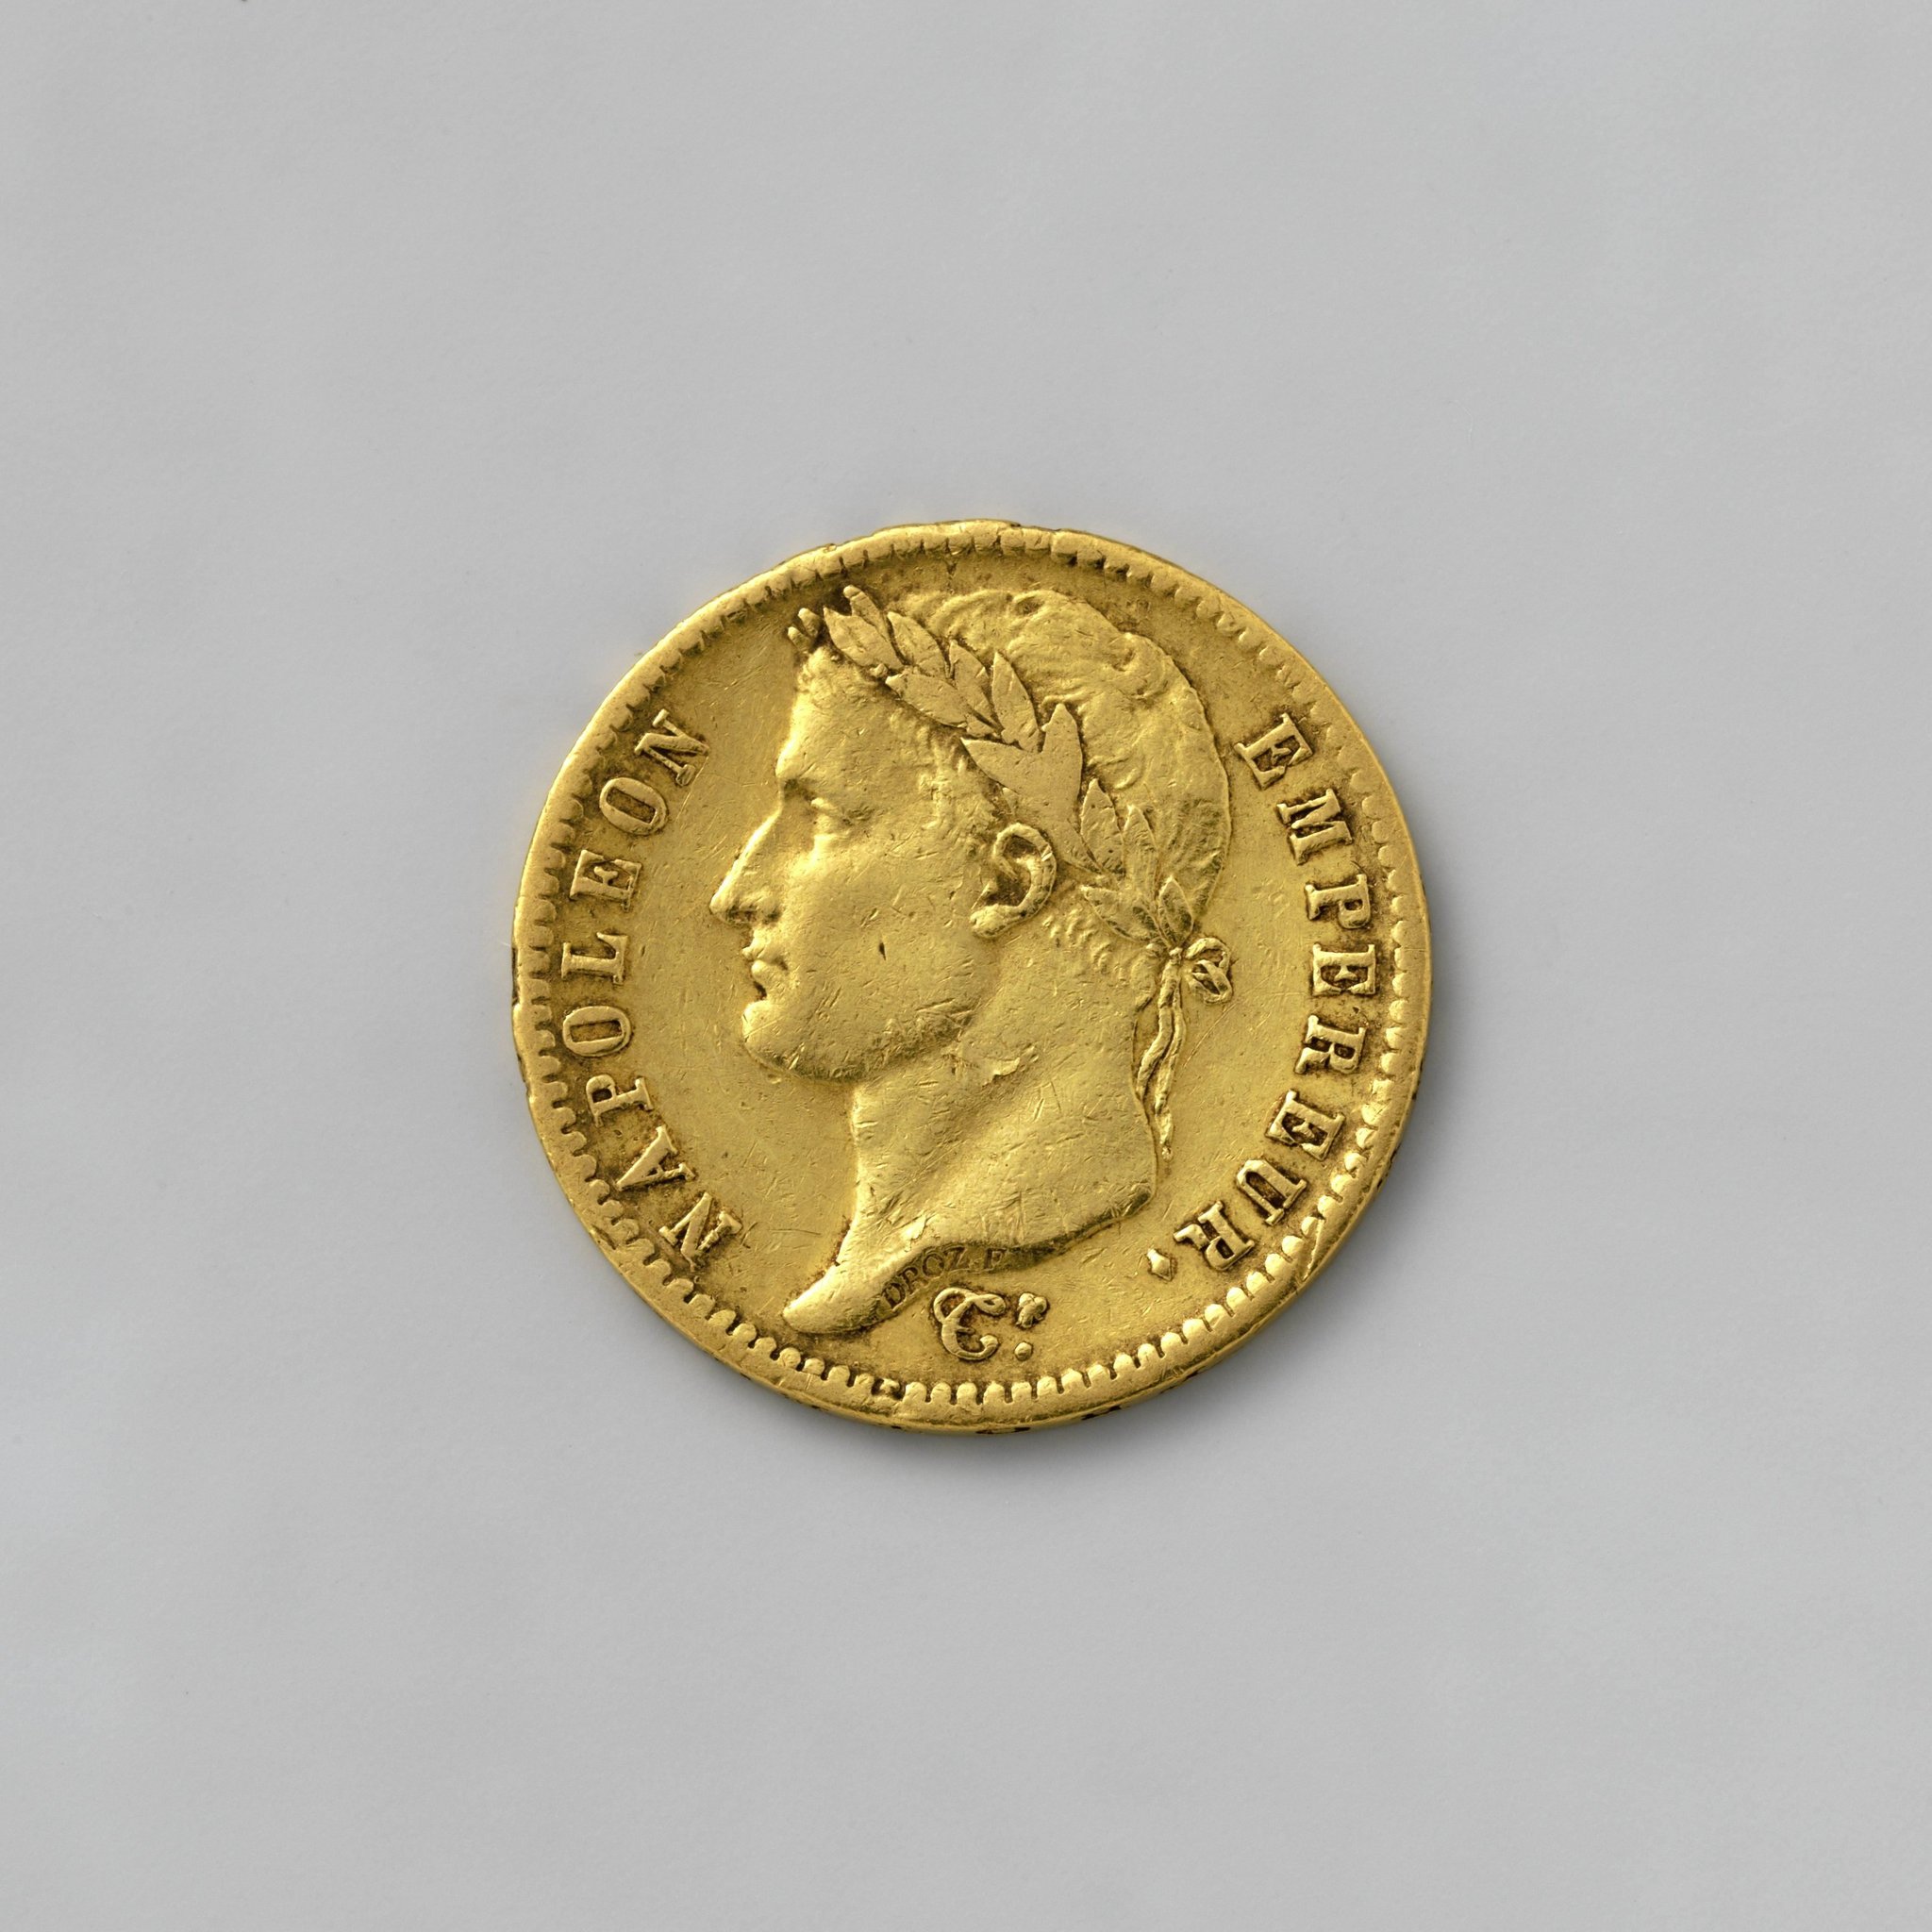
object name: twintig franc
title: Nederland, bij Frankrijk ingelijfd, 20 francs, 1813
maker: napoleon i (emperor of the french)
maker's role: generaal, keizer, staatsman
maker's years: 1769-1821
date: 1813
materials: gold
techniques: striking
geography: utrecht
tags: napoleon i (emperor of the french), netherlands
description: Gouden munt. Voorzijde: gelauwerd borstbeeld van Napoleon I naar links. Keerzijde: binnen olijfkrans waarde-aanduiding 20 francs. Jaartal in omschrift onderaan. Randschrift.